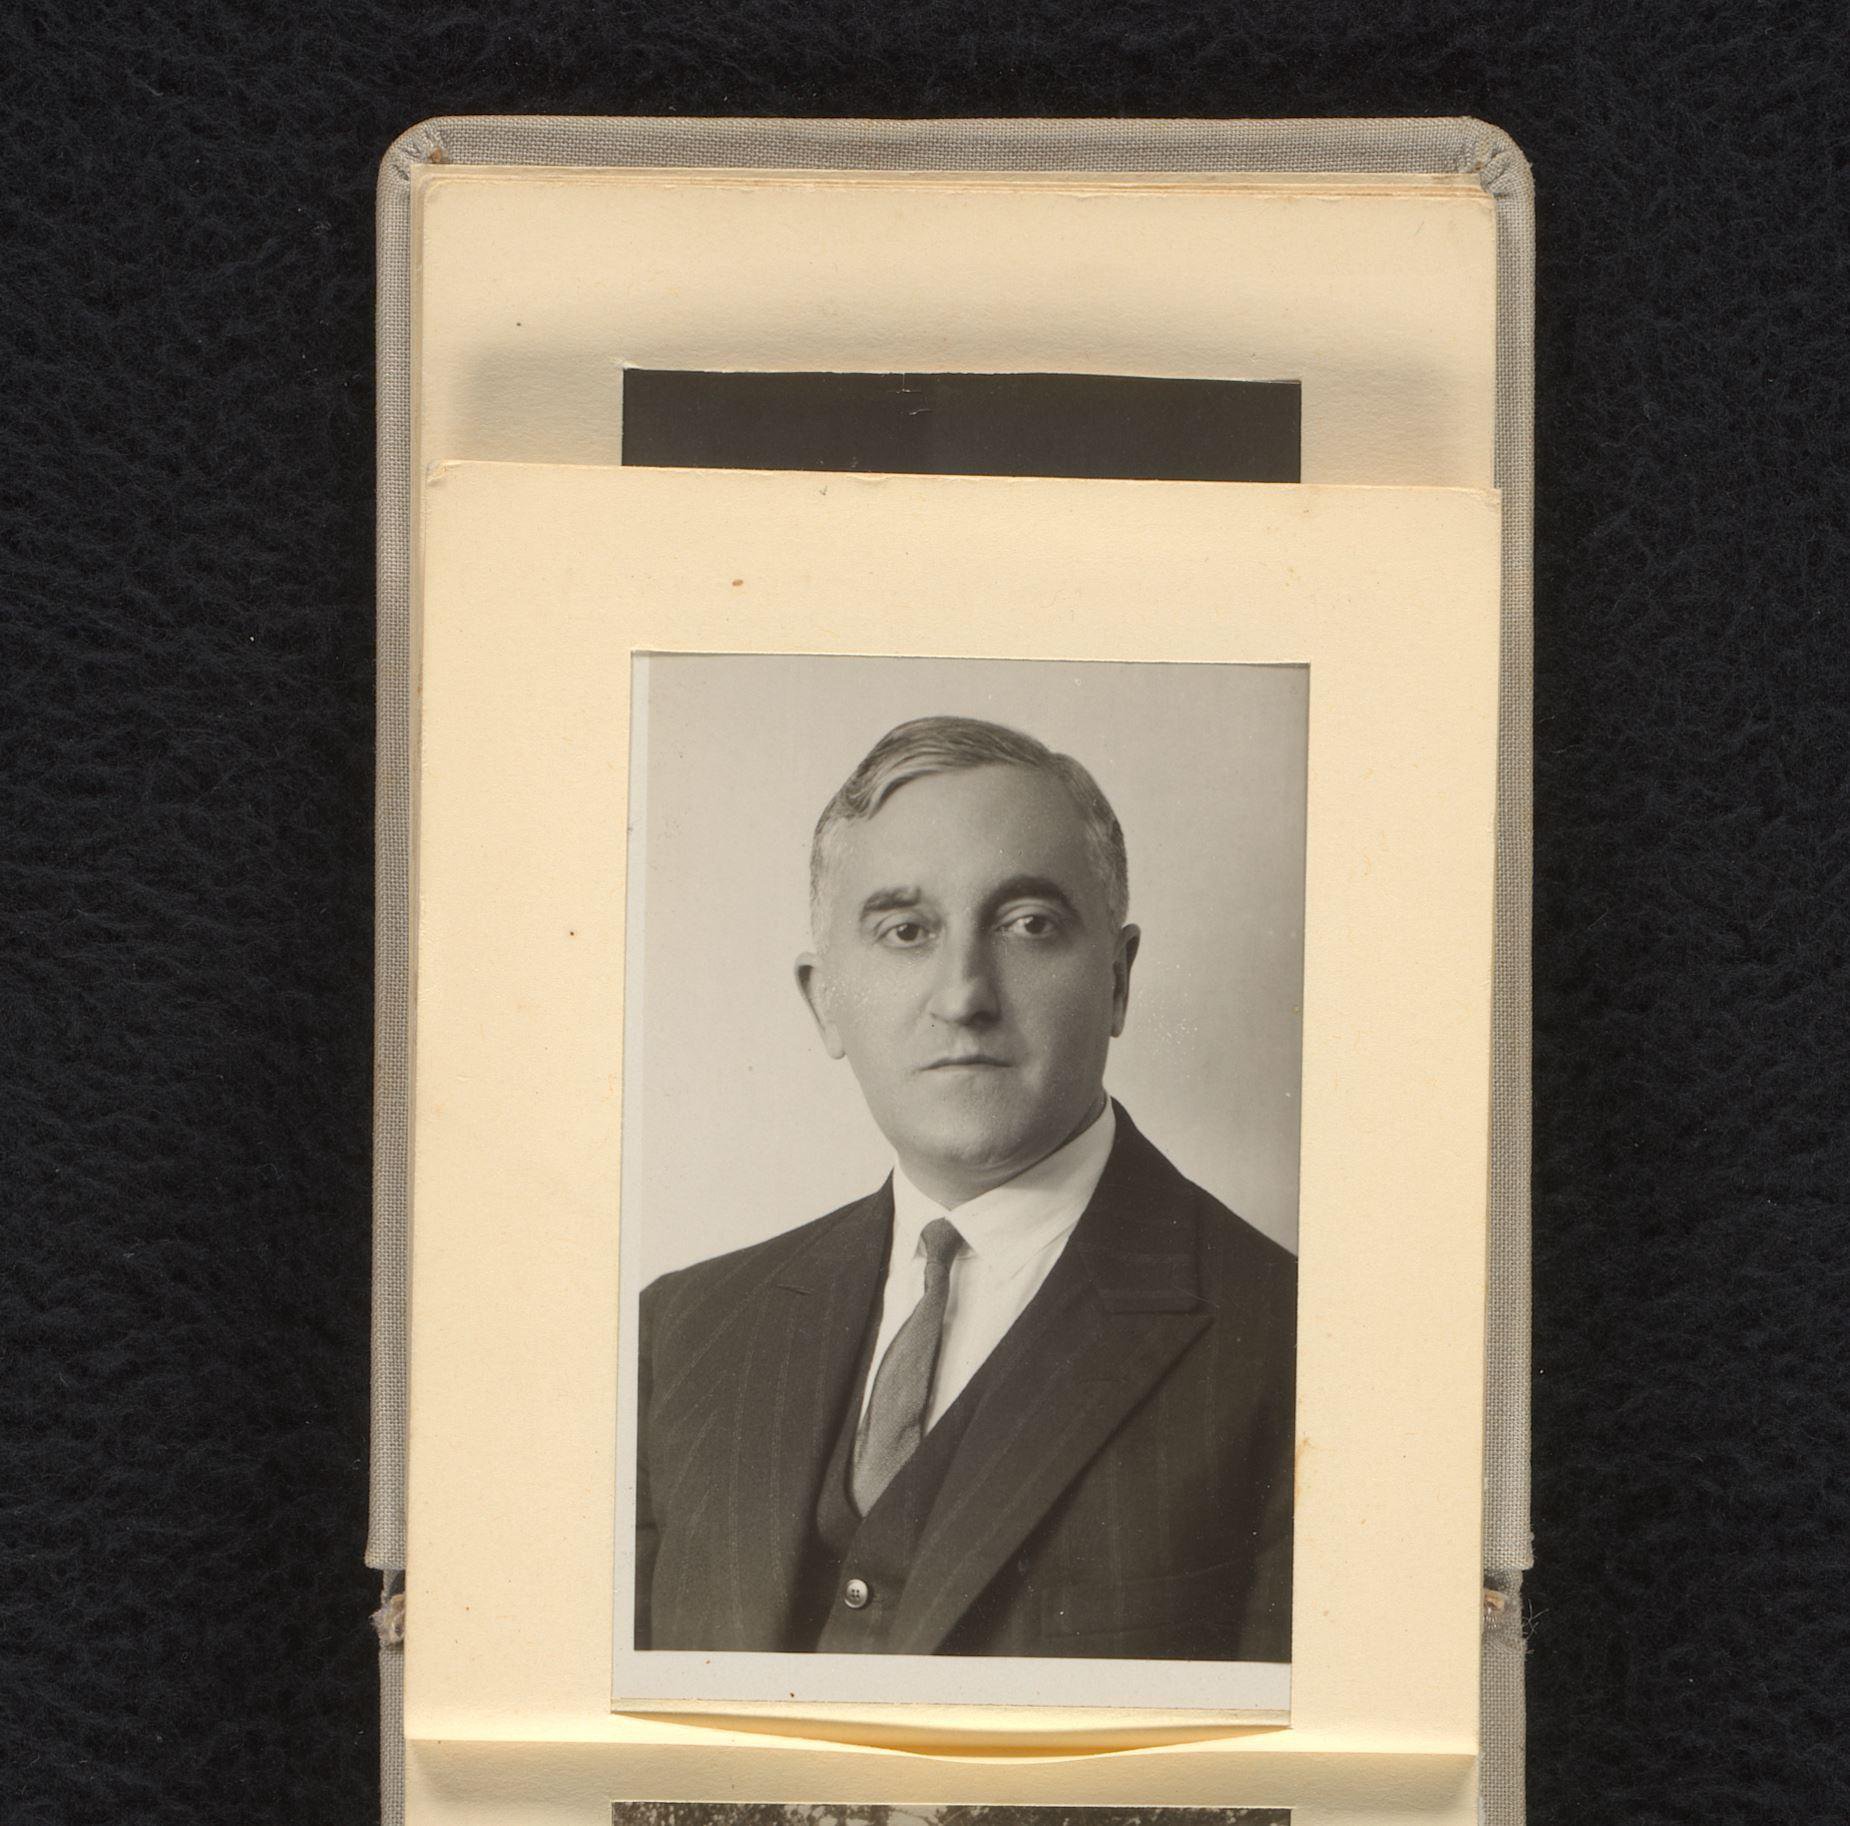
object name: photograph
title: Portret van Eugen Wachenheimer, 1921-1937, Duitsland?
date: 1921-1937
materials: paper, photographic support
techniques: gelatin silver print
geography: germany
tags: eugen wachenheimer, historical persons, germany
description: Albumblad bevat een foto van Eugen Wachenheimer. Onderdeel van het fotoalbum met diverse foto's van de jeugd van Isabel Wachenheimer voor en tijdens de oorlog en diverse momenten van haar volwassen leven na de Tweede Wereldoorlog.